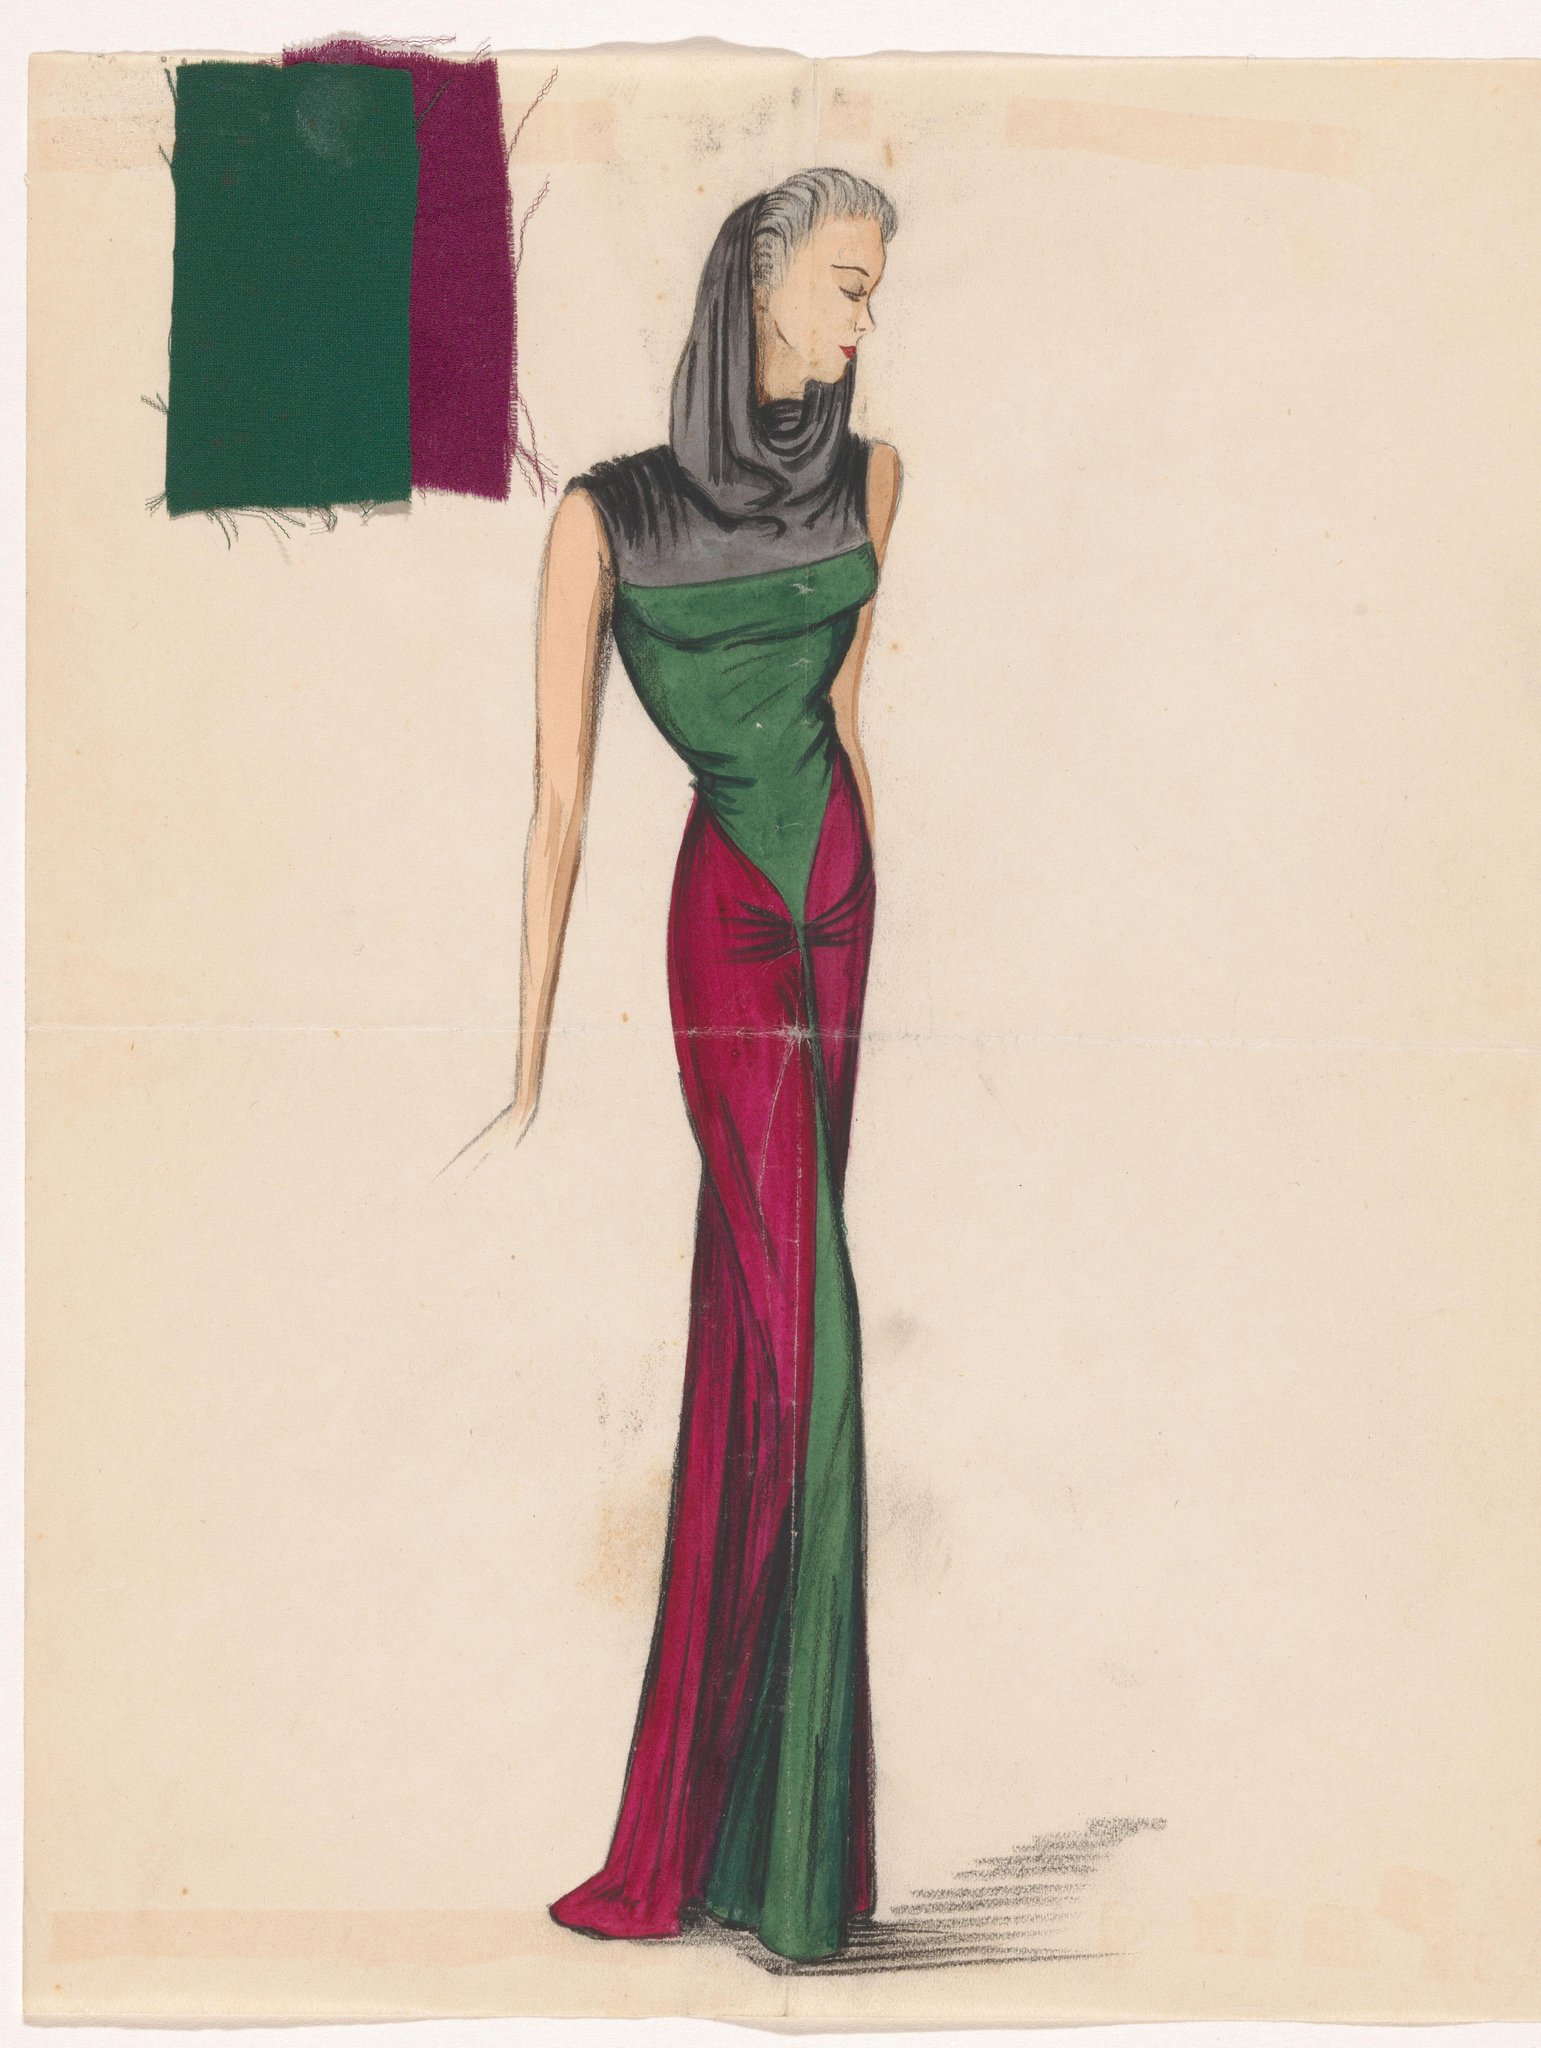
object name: fashion plate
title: Avondjapon van ALIX van dieproze en donkergroene zijden jersey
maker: alix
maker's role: modeontwerper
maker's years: 1903-1993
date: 1938-1939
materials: paper, pencil, watercolor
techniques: brush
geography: paris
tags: dress, gown: evening dress (+ women's clothes), fashion plates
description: Avondjapon van dieproze en donkergroene zijden jersey, toegeschreven aan Alix, later bekend als 'Madame Grès'. Sluik mouwloos model met aansluitend lijf en capuchon. Rok tot aan de grond. In de linker bovenhoek een staaltje dieproze en donkergroene zijden jersey